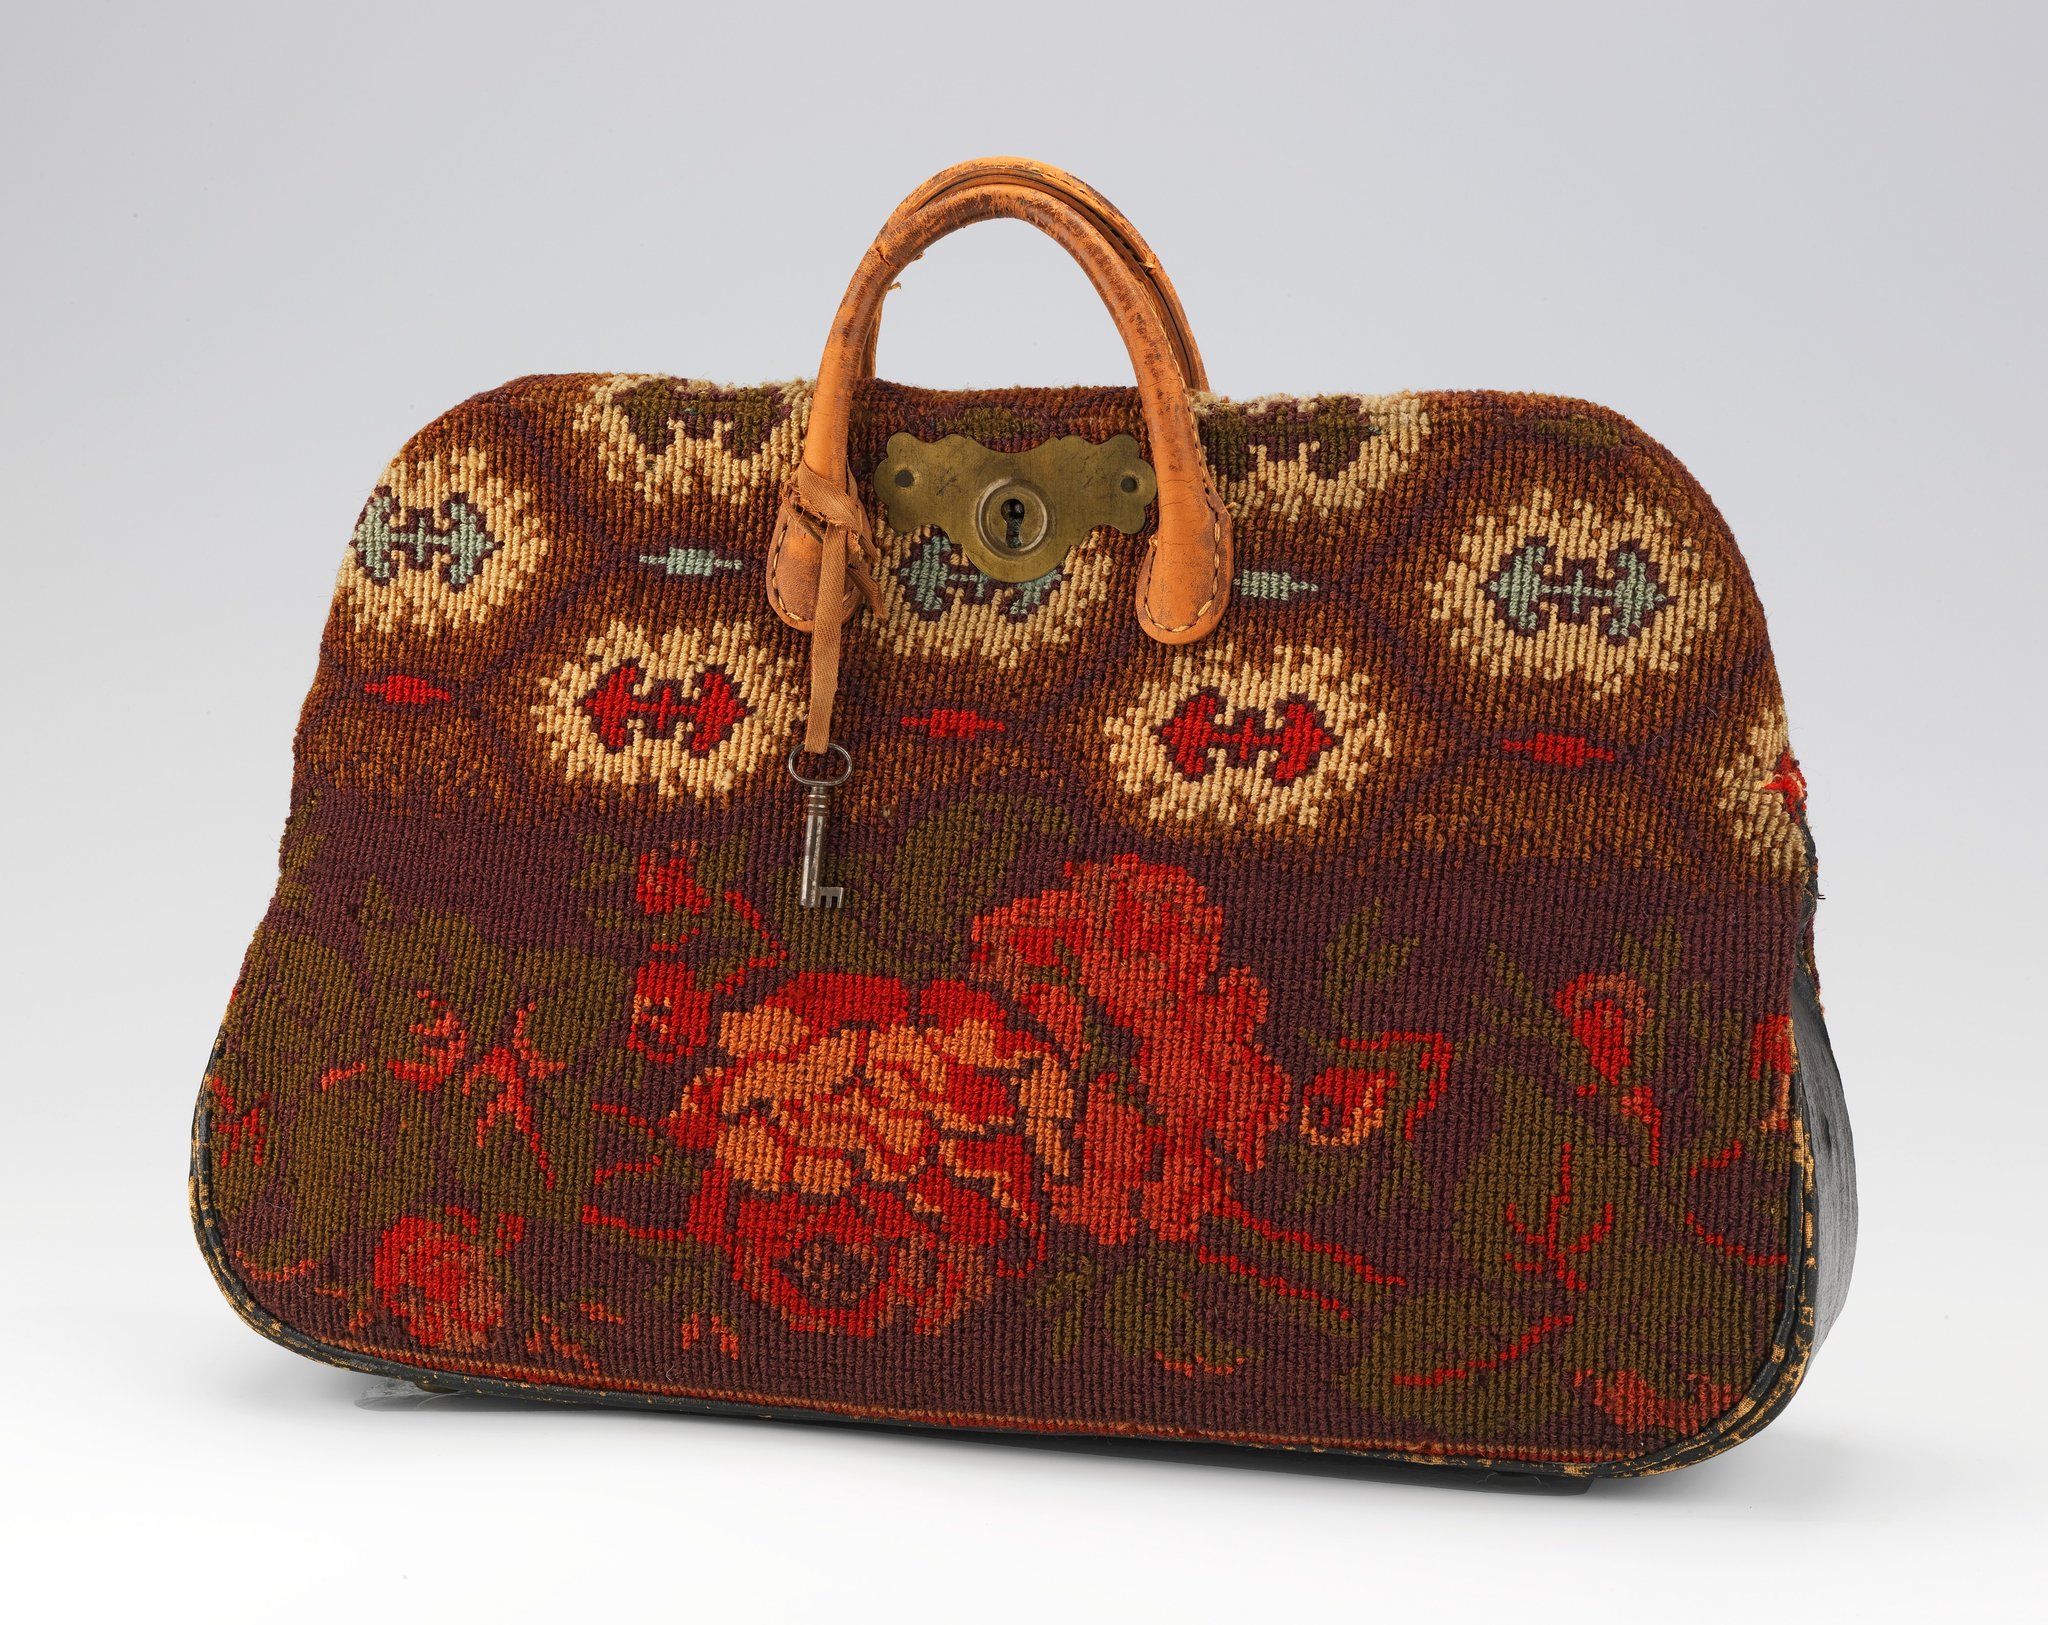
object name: carpetbag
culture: american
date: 1860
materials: cotton, leather, metal, wool